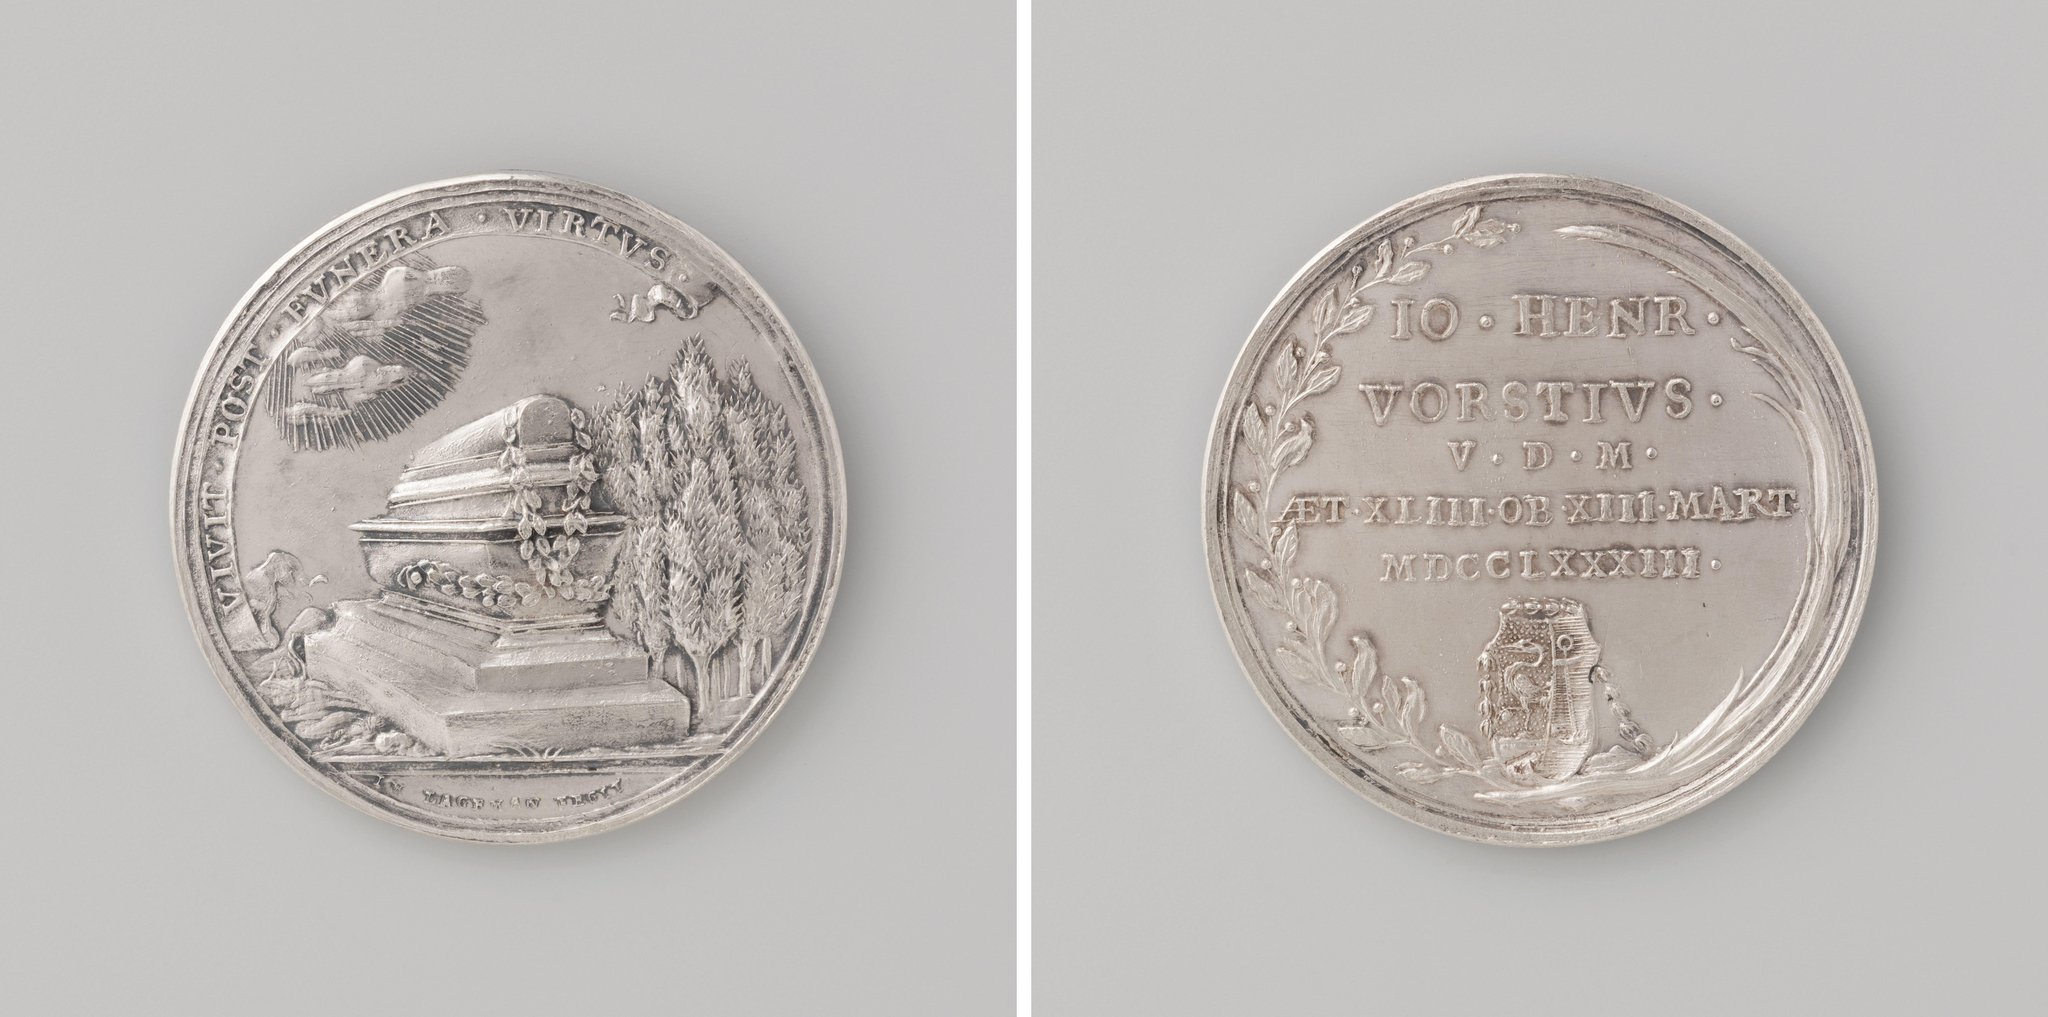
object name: family medal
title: Overlijden van Johan Hendrik Vorstius, Luthers predikant te Monnickendam, Alkmaar, 's-Gravenhage en Amsterdam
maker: johannes michiel lageman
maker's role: silversmith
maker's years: 1735-1809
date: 1783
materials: silver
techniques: striking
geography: amsterdam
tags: cleves, the hague, amsterdam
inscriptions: signature: ‘I.M. LAGERMAN FECIT’, circumscription: ‘VIVIT POST FVNERA VIRTVS’, inscription: ‘IO. HENR./ VORSTIVS./ V. D. M./ ÆT XLIII. OB. XIII. MART./ MDCCLXXXIII’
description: Zilveren penning. Voorzijde: rij cypressen naast een met lauwerkransen omhangen graftombe, beschenen door hemellicht binnen omschrift; afsnede: signatuur. Keerzijde: opschrift boven wapenschild binnen krans van samengebonden palm- en mirtetak.